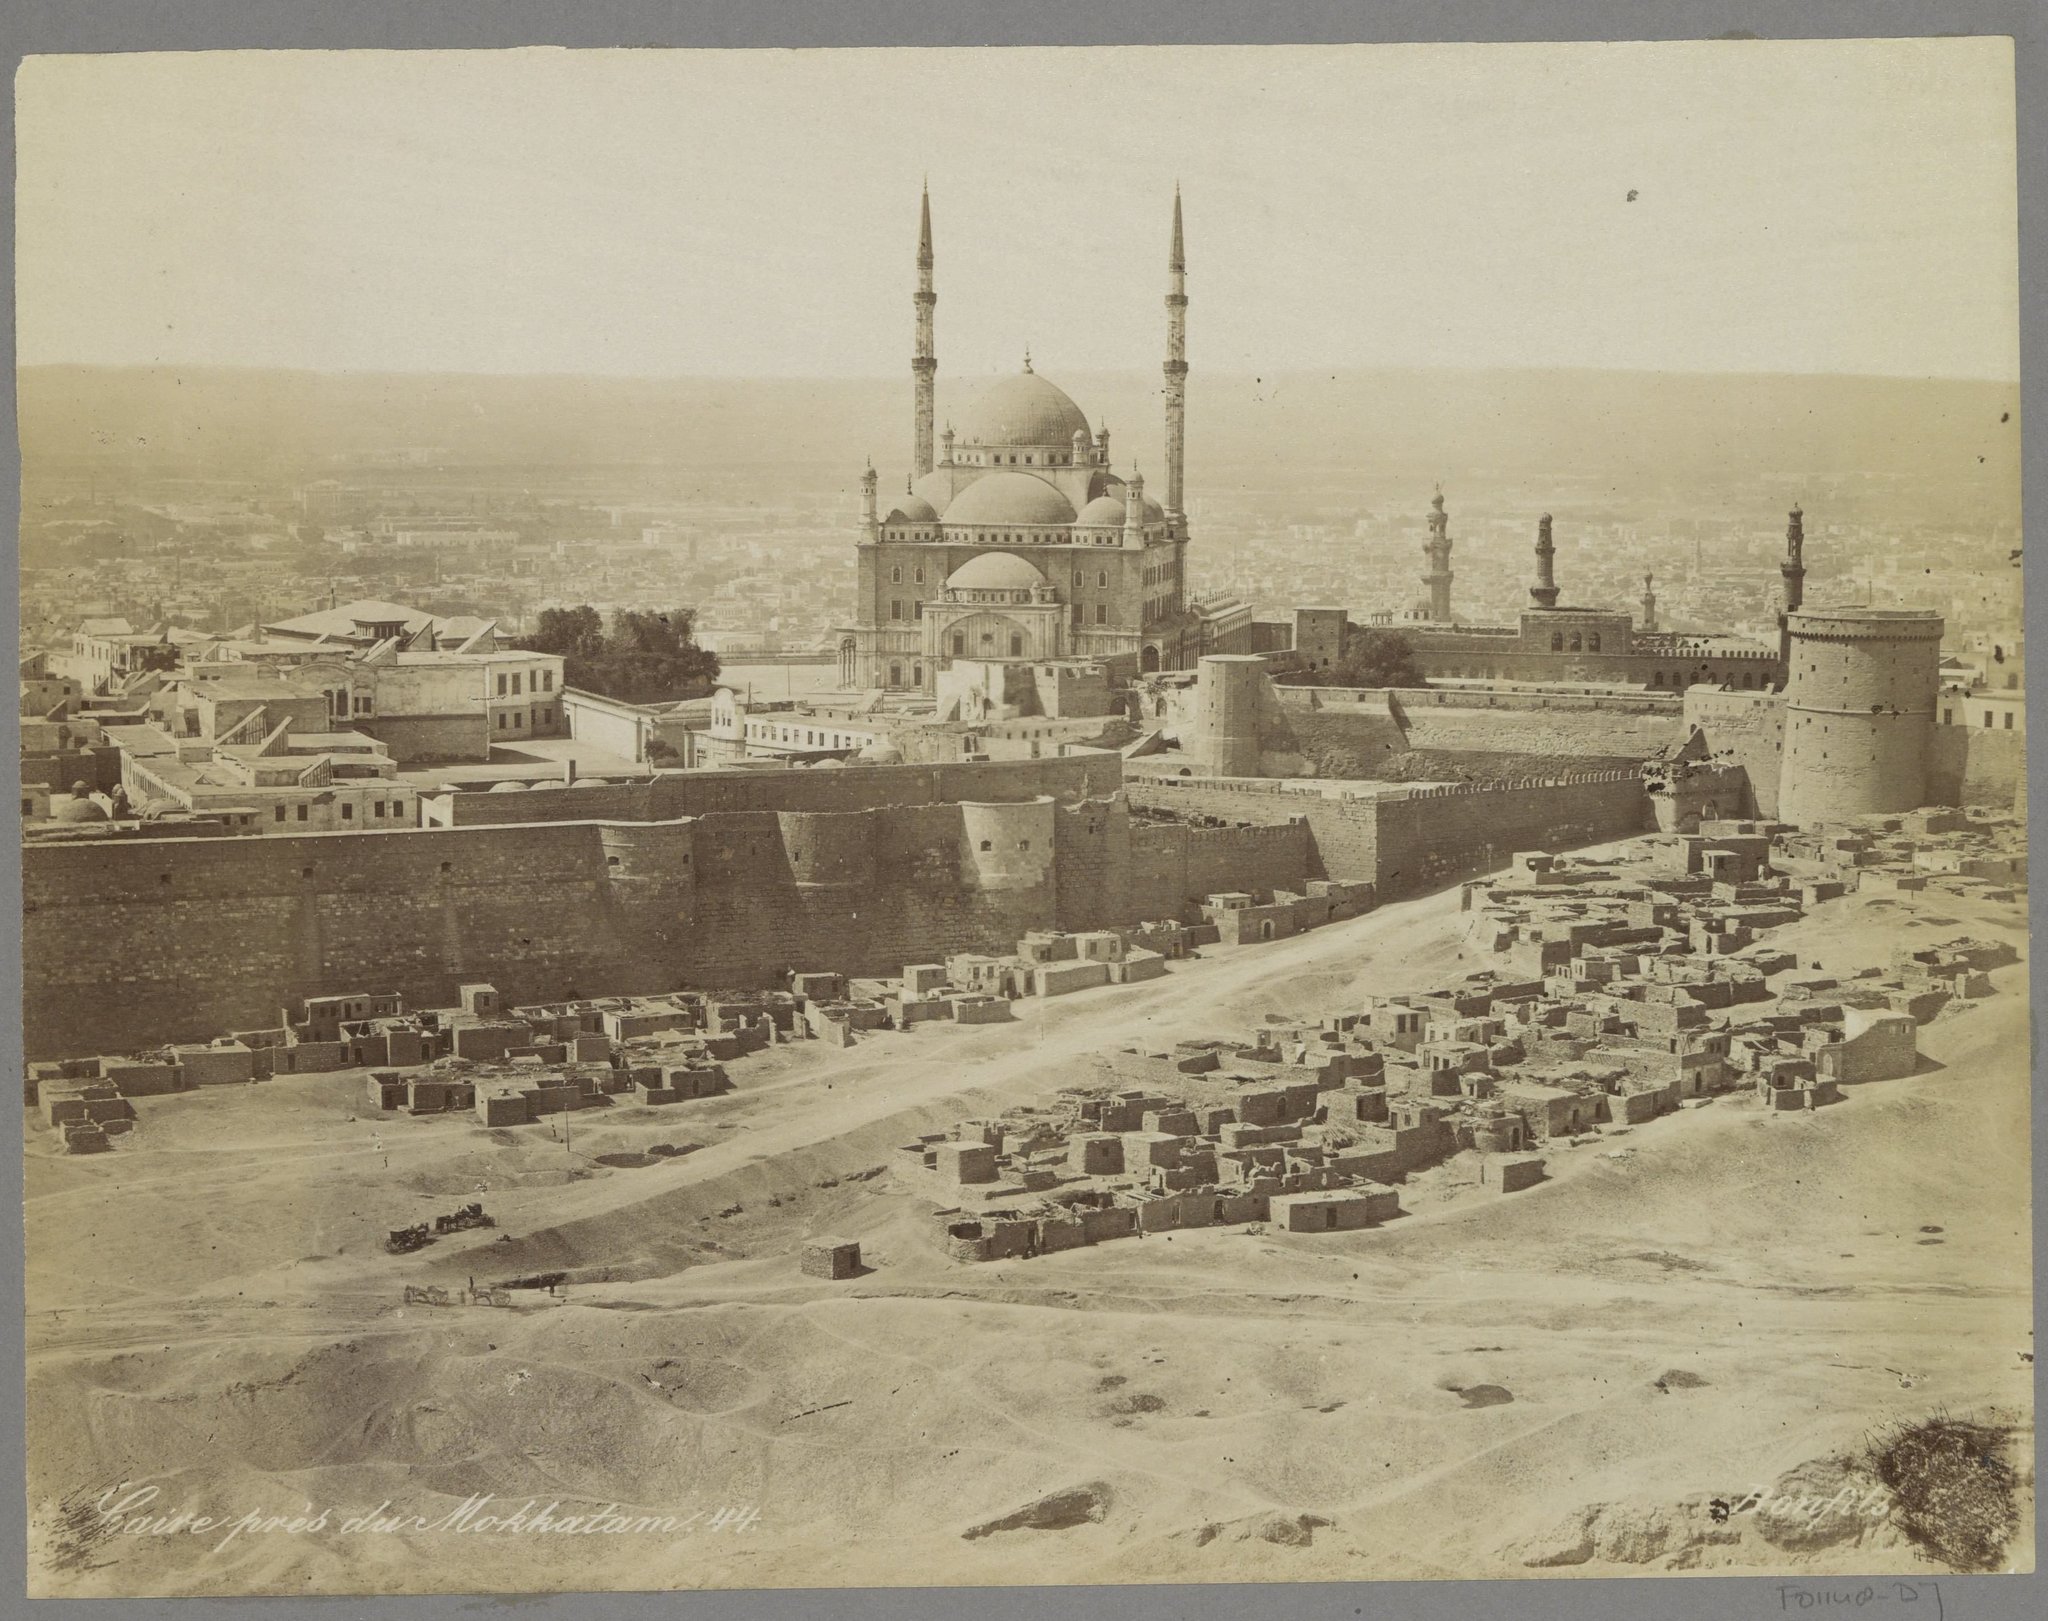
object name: album leaf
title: Gezicht op Caïro bij de wijk Mokkatam met stadsmuren en moskee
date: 1895-1905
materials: paper, photographic support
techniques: albumen print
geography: cairo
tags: temple, shrine ~ islam, mohammedanism, prospect of city, town panorama, silhouette of city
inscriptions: negative number: ‘44’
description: Onderdeel van Reisalbum met foto's van bezienswaardigheden in Griekenland en Egypte.